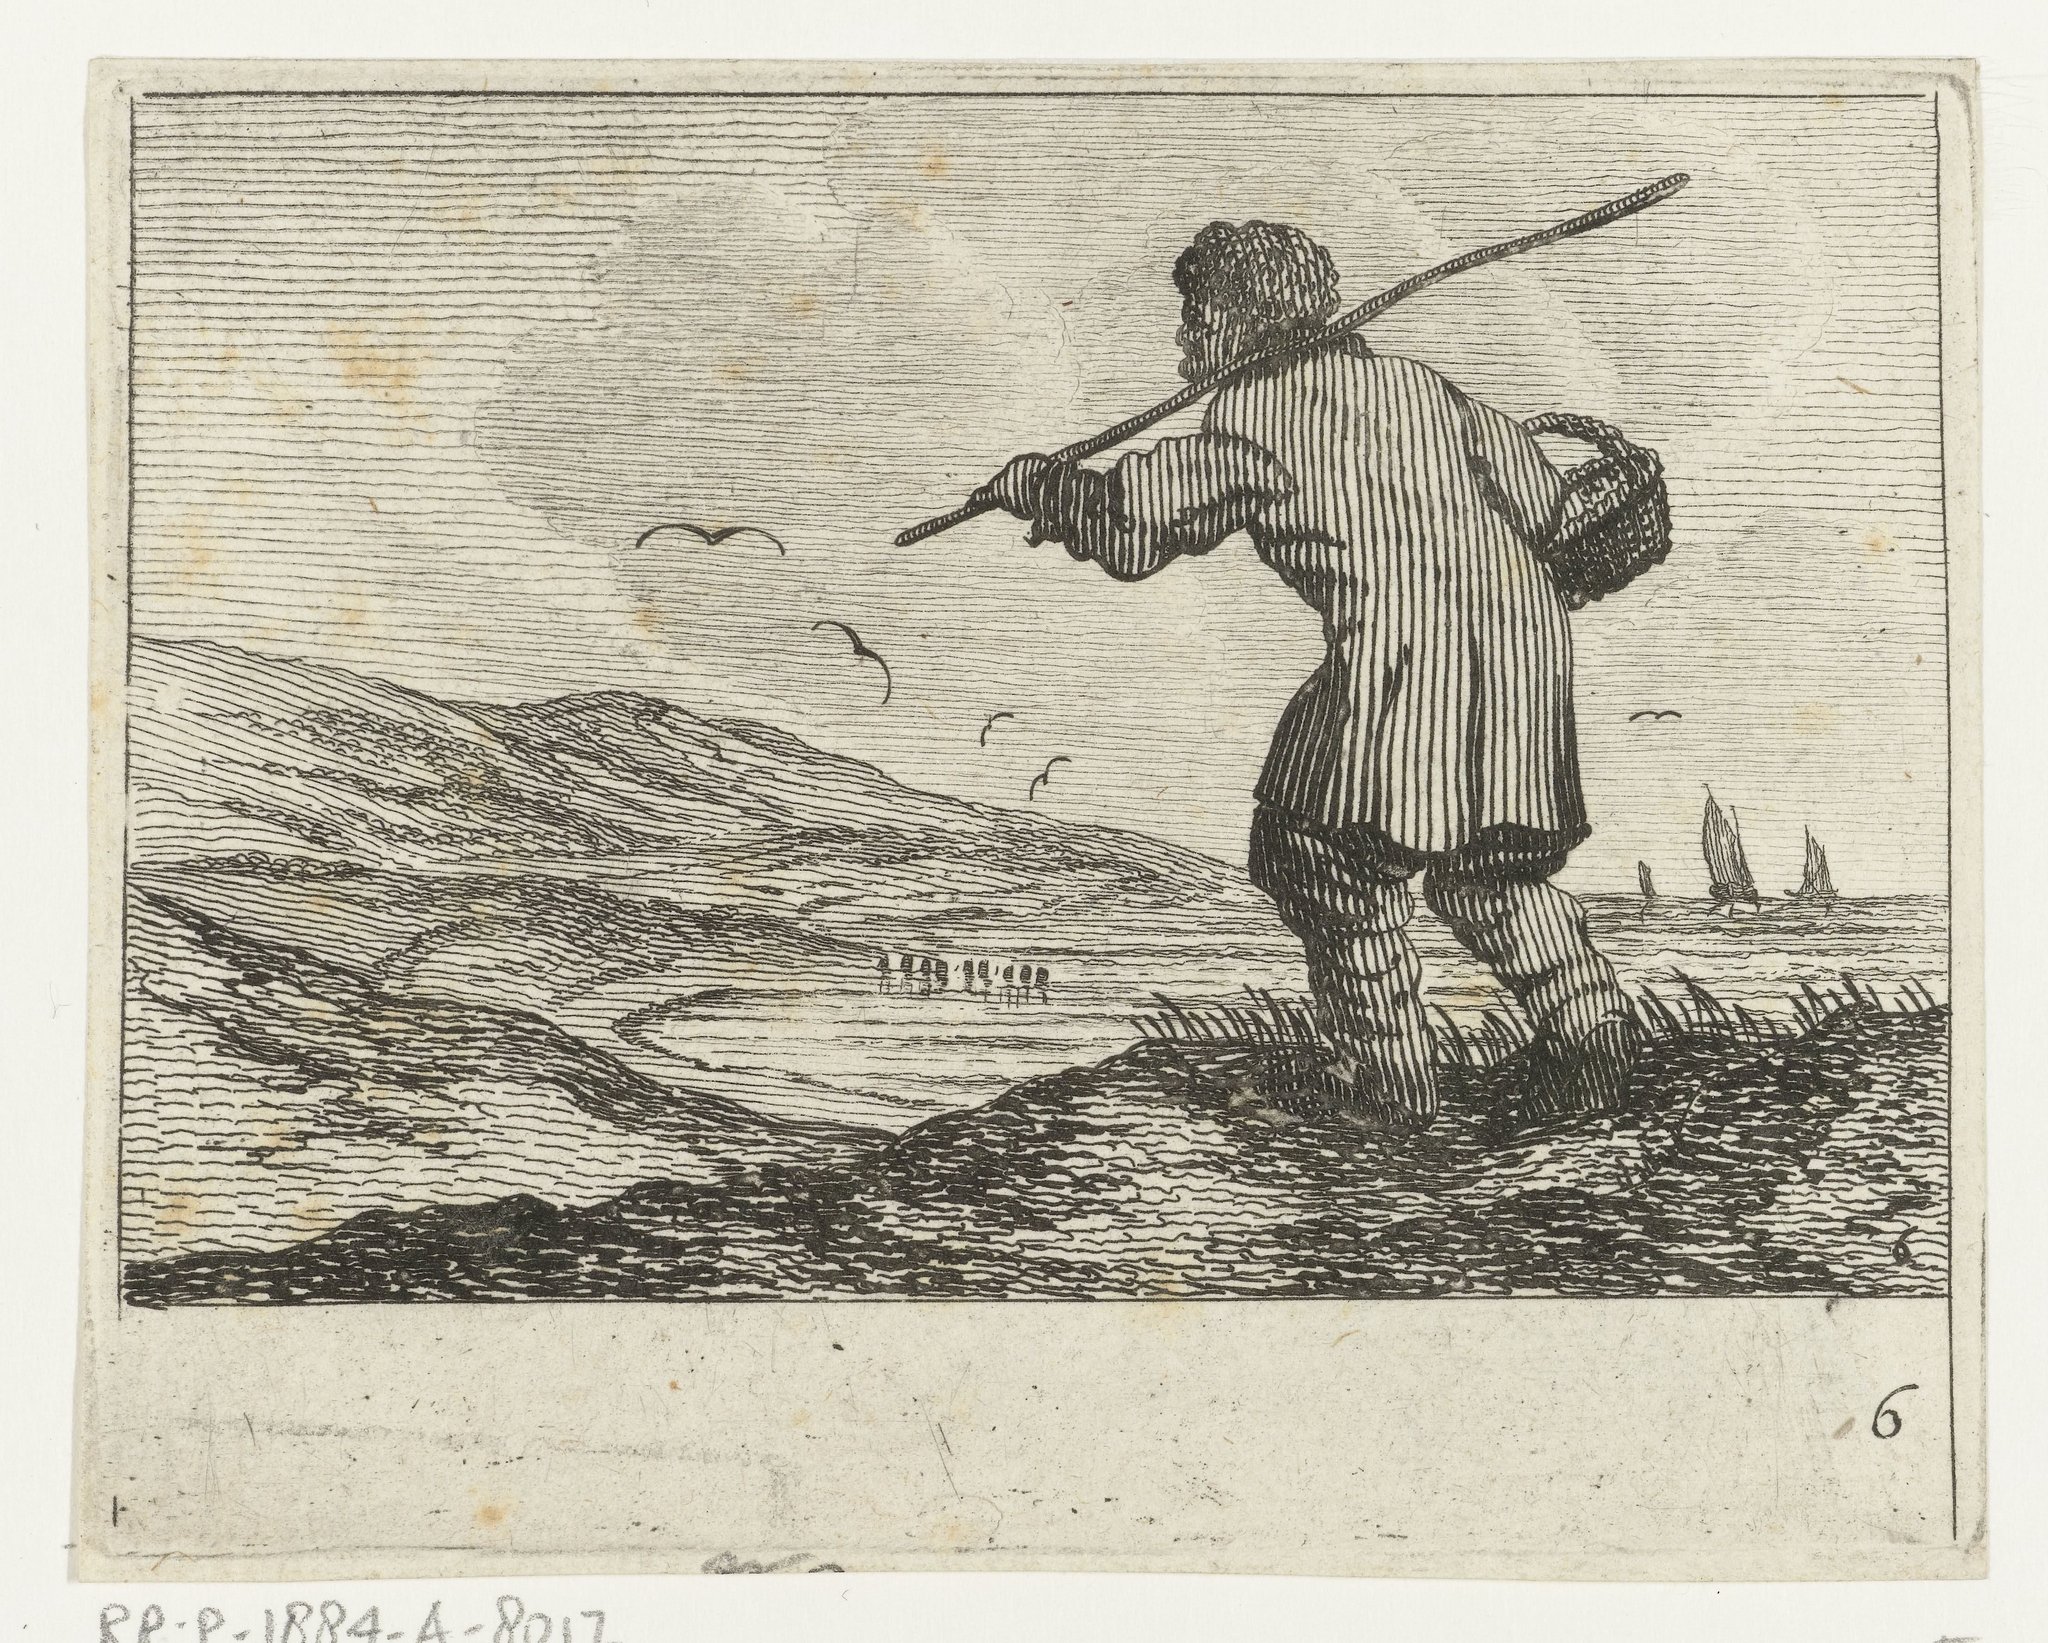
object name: print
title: Verscheyden Stranden en water gesichten gedaen door Jan Percelles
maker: gillis van scheyndel (i)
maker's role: draughtsman, print maker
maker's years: 1595-1660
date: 1645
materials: paper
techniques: etching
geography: northern netherlands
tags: dune coast, carrying something in basket, bag, rucksack, etc.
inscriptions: collector's mark: Lugt 2228